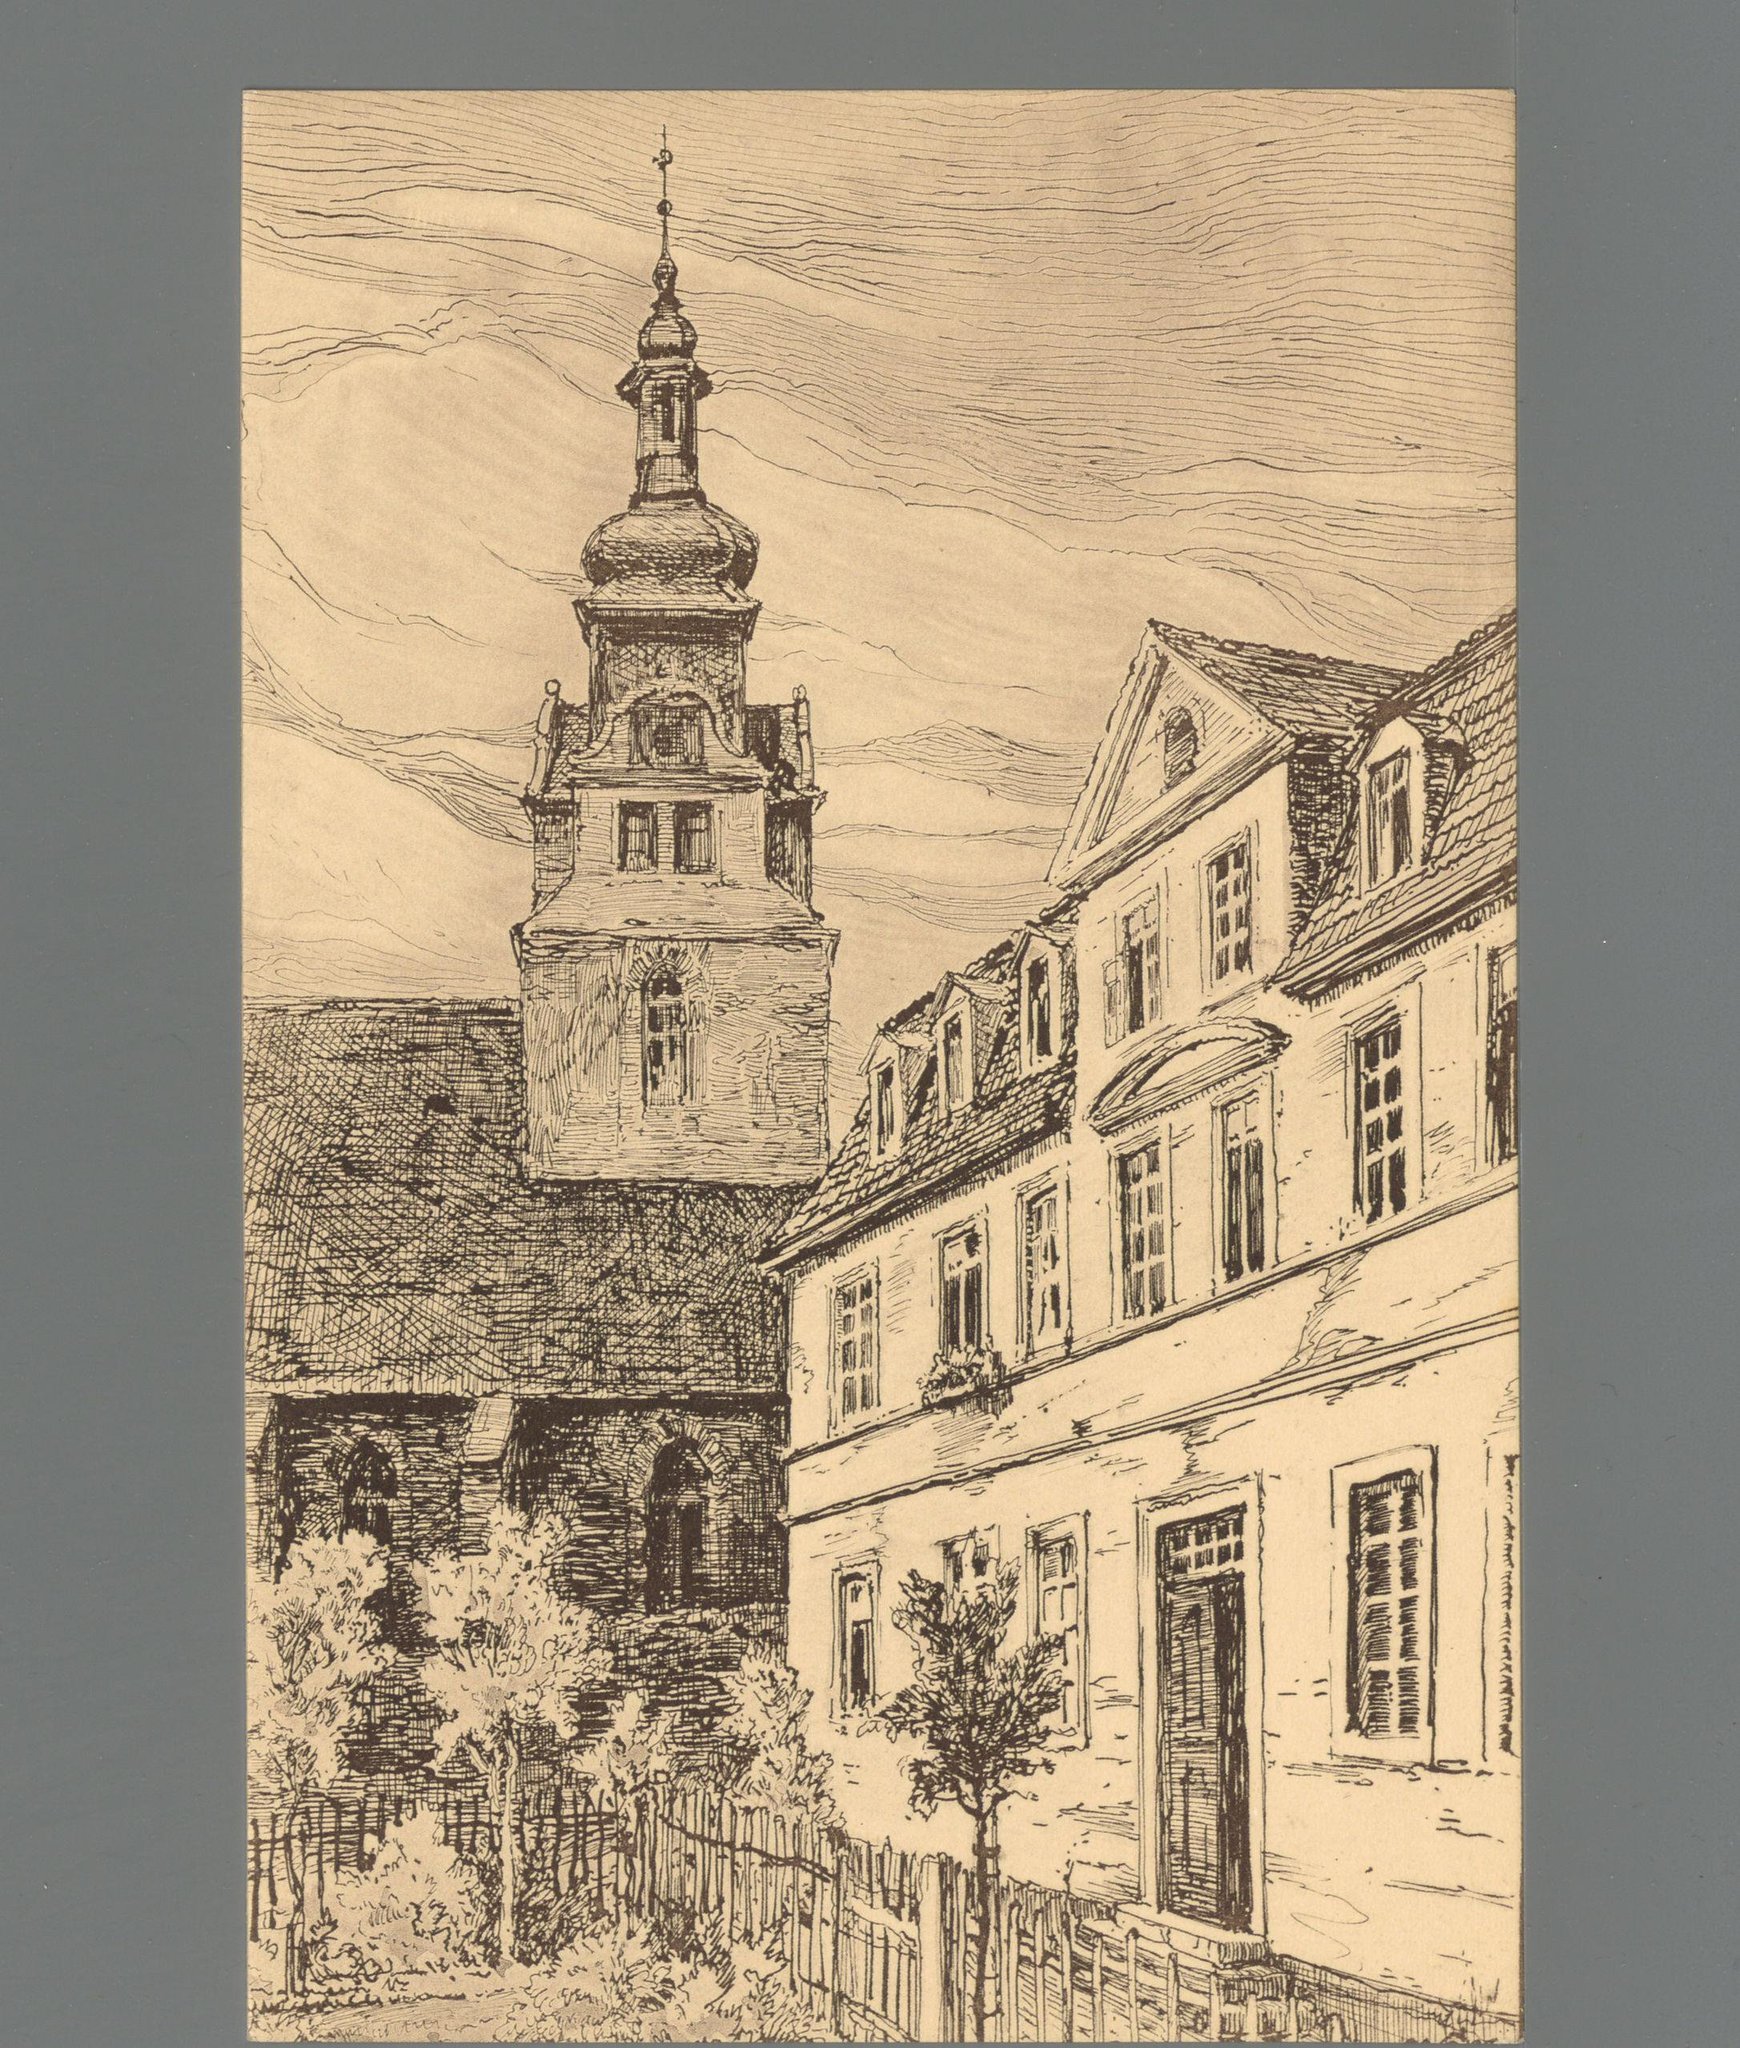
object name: reproduction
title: Rudolstadt. Der Heisenhof und Stadtkirche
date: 1915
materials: cardboard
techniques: photograph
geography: rudolstadt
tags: church (exterior)